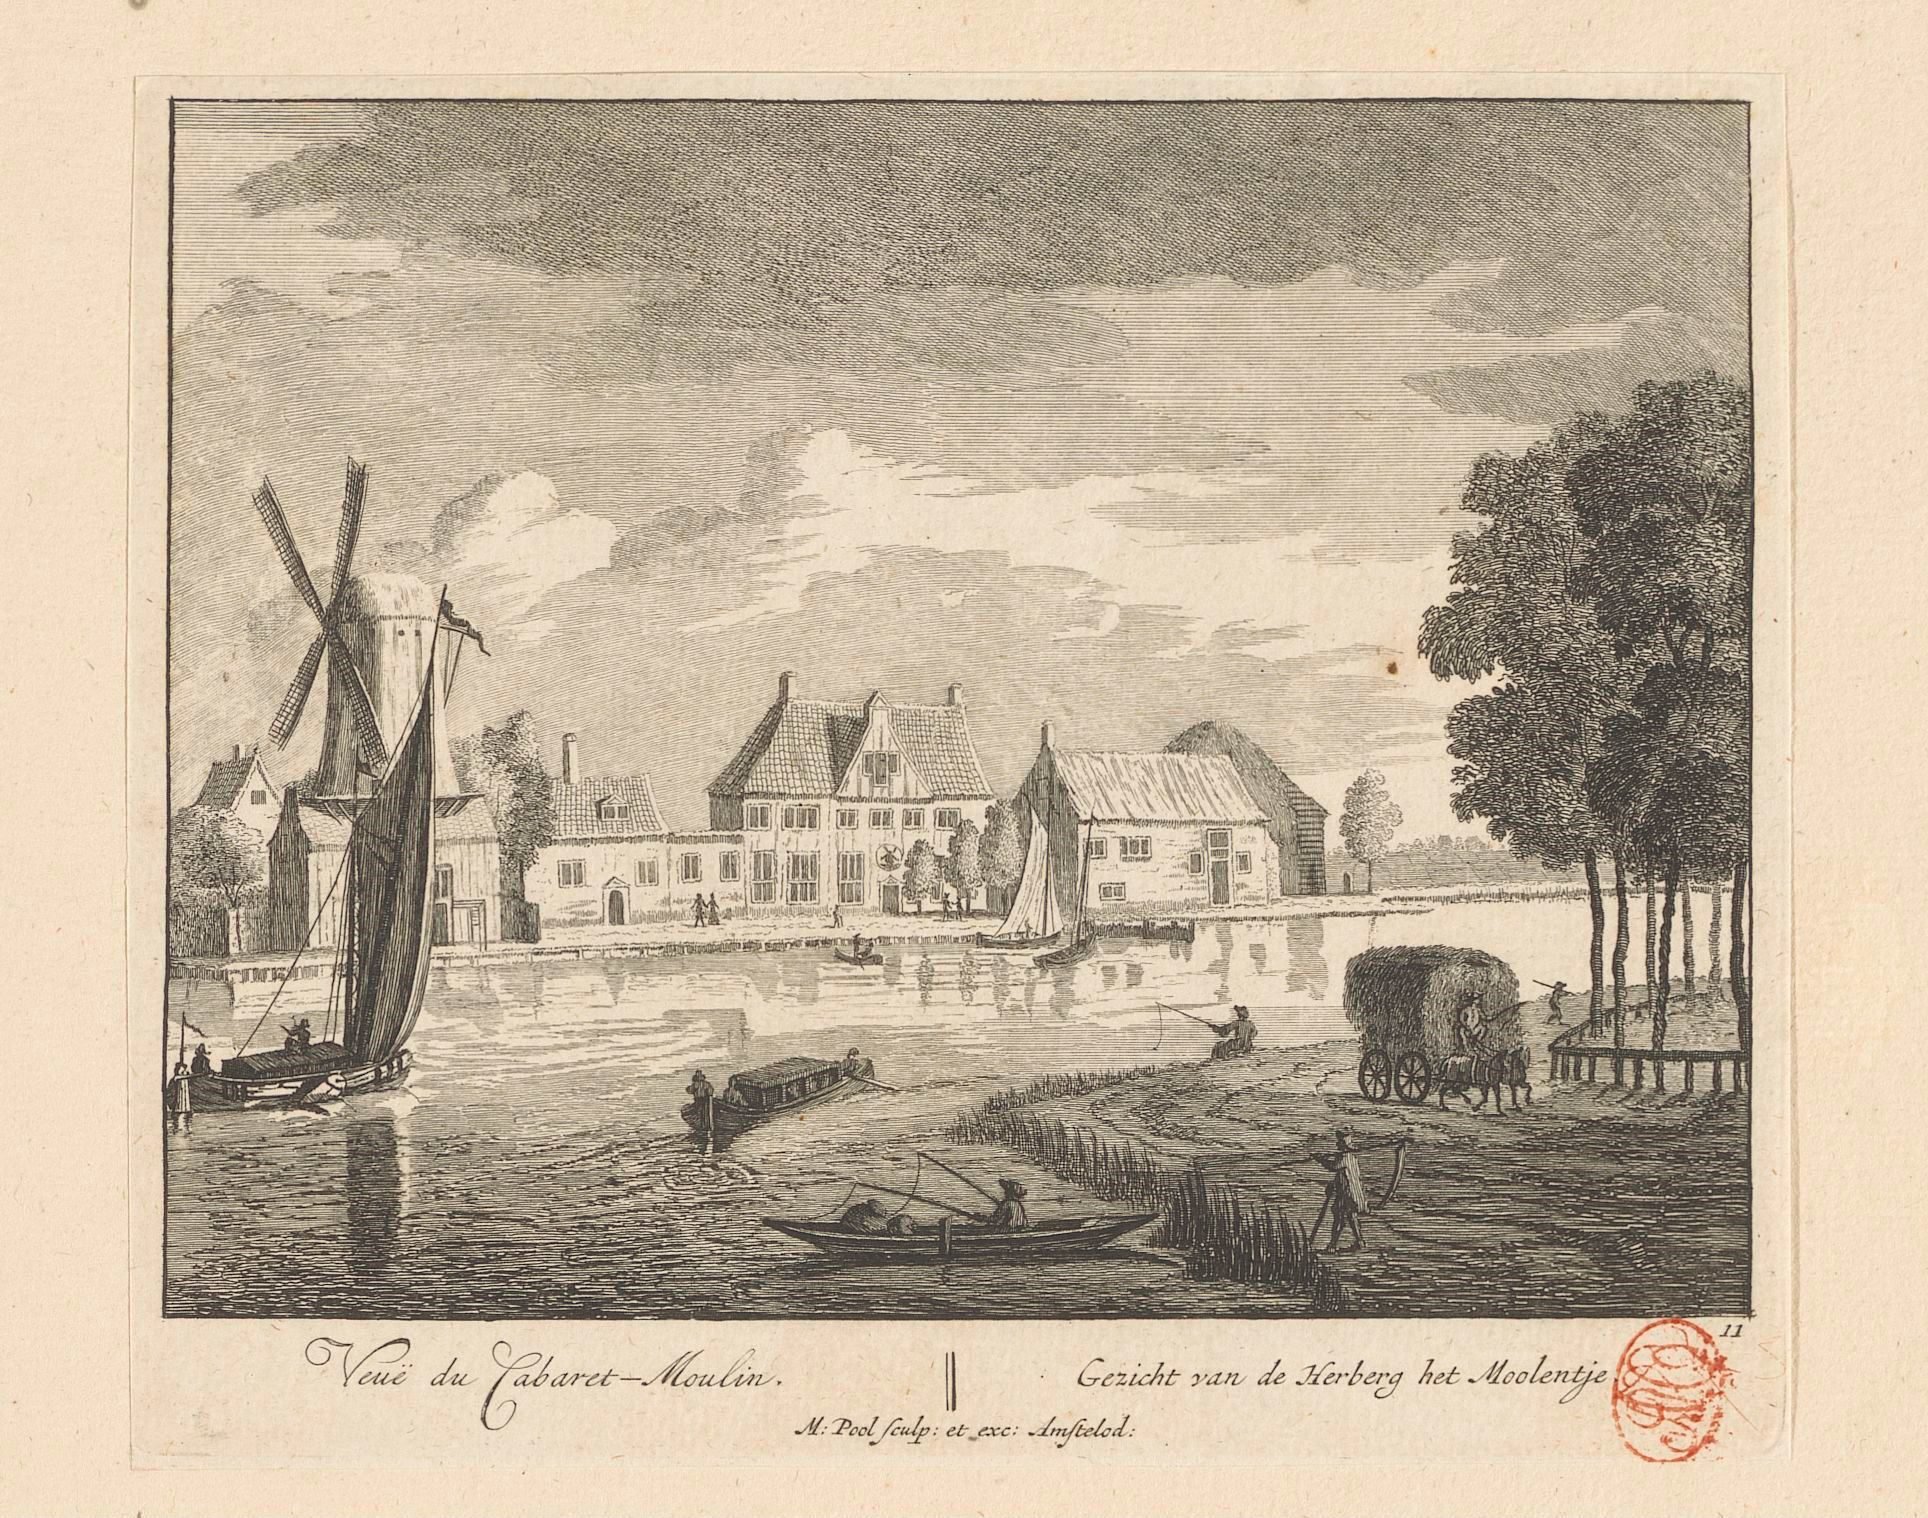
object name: print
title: Gezicht op de Amstel bij herberg het Molentje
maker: matthijs pool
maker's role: print maker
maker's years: 1676-1740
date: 1708-1740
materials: paper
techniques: engraving, etching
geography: amsterdam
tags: sailing-ship, sailing-boat, river, rowing-boat, canoe, etc., hotel, hostelry, inn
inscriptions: collector's mark: Lugt 2233, collector's mark: Lugt 195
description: Prent gebruikt in: Pool, Matthijs. Verscheyde gesigten van de vermaarde rievier de buyten Amstel van de stadt Amsterdam, tot het dorp Ouwerkerk (…) / Plusieurs veuës et perspectives de la fameuse riviére de Buyten-Amstel depuis Amsterdam jusqu'au village d'Ouwerkerk (…). Amsterdam: Matthijs Pool, z.j. [1708-1740].